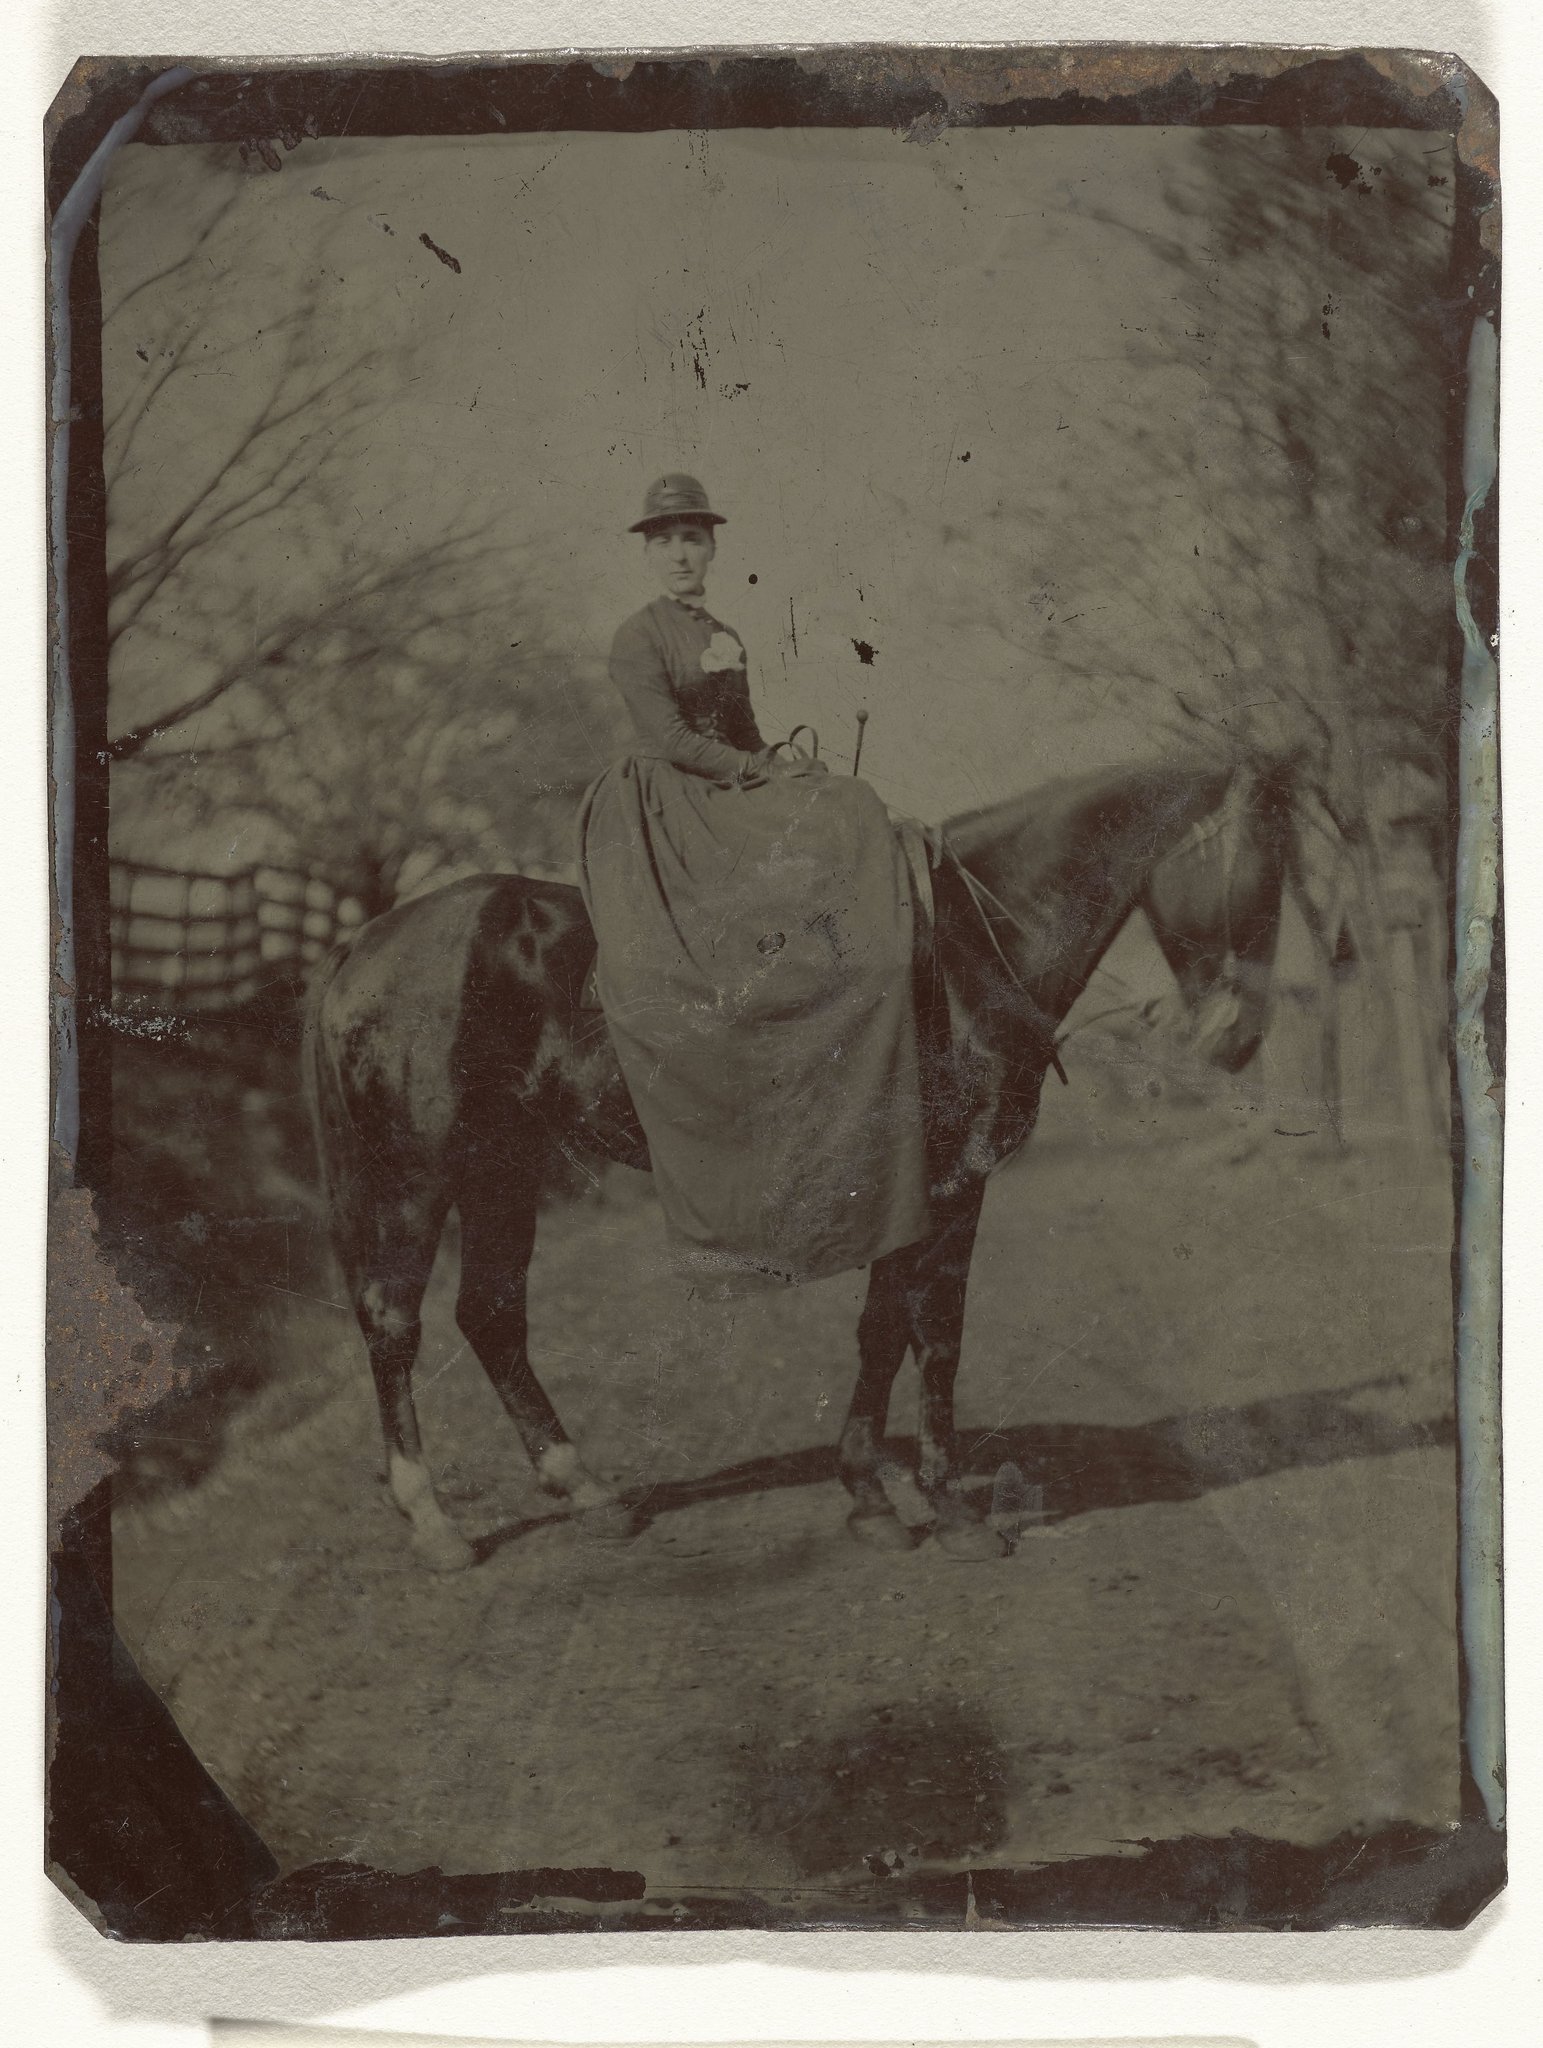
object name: photograph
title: Vrouw te paard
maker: Anonymous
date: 1890-1910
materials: metal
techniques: ferrotyping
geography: united states